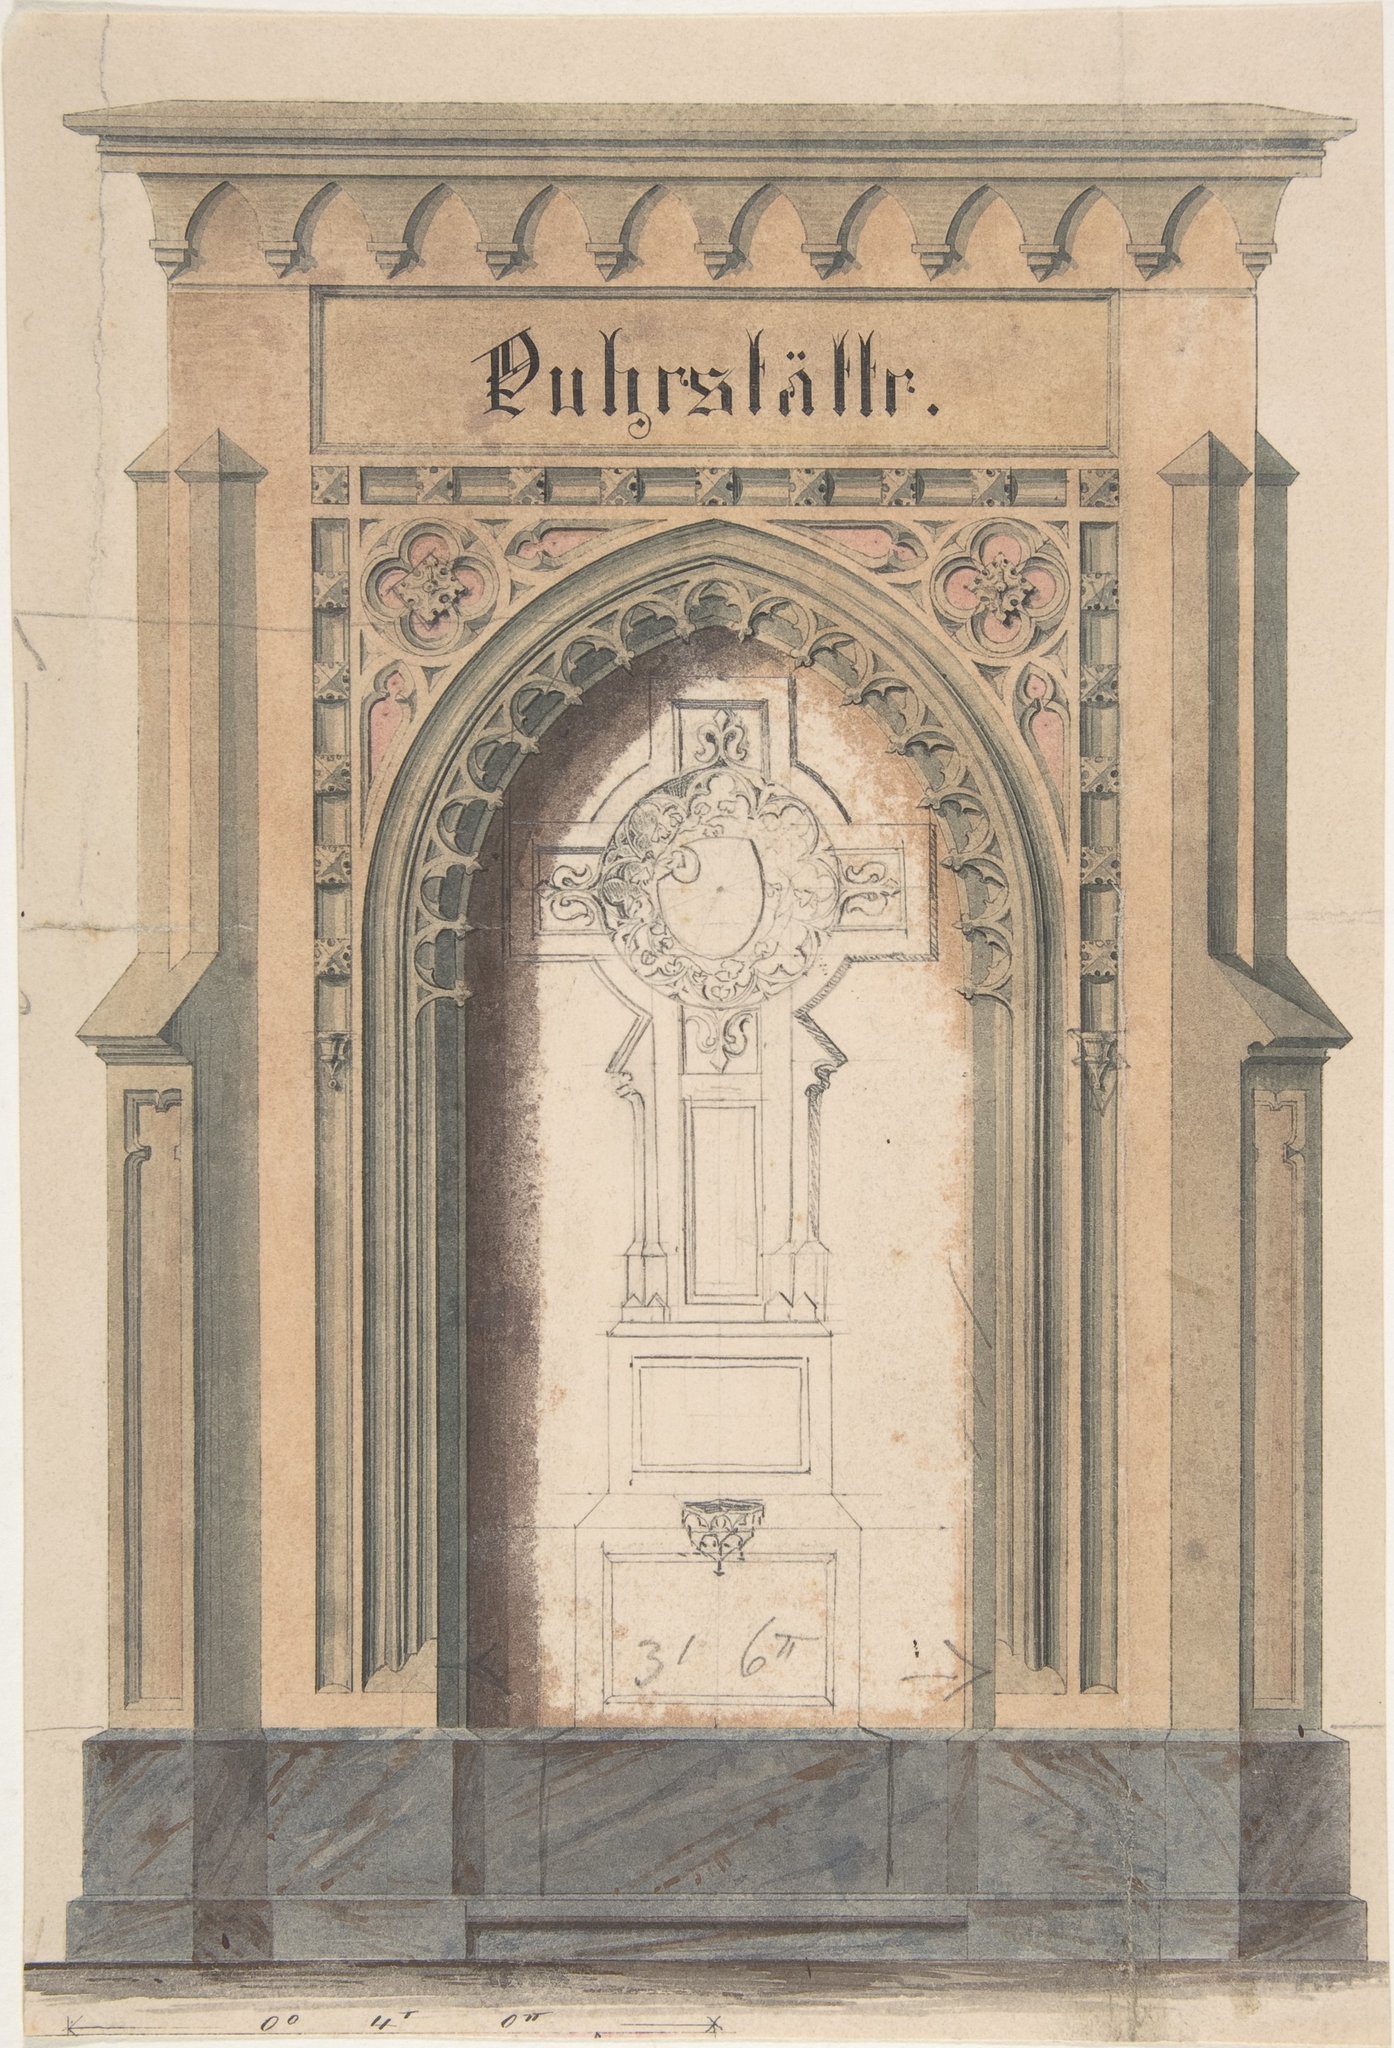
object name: drawing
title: Design for gothic archway and cross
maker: anonymous, german, 19th century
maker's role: artist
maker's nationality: german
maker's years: 1800-1899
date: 1801-1900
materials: graphite, ink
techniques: brush, pen, wash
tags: architecture,arches,cross